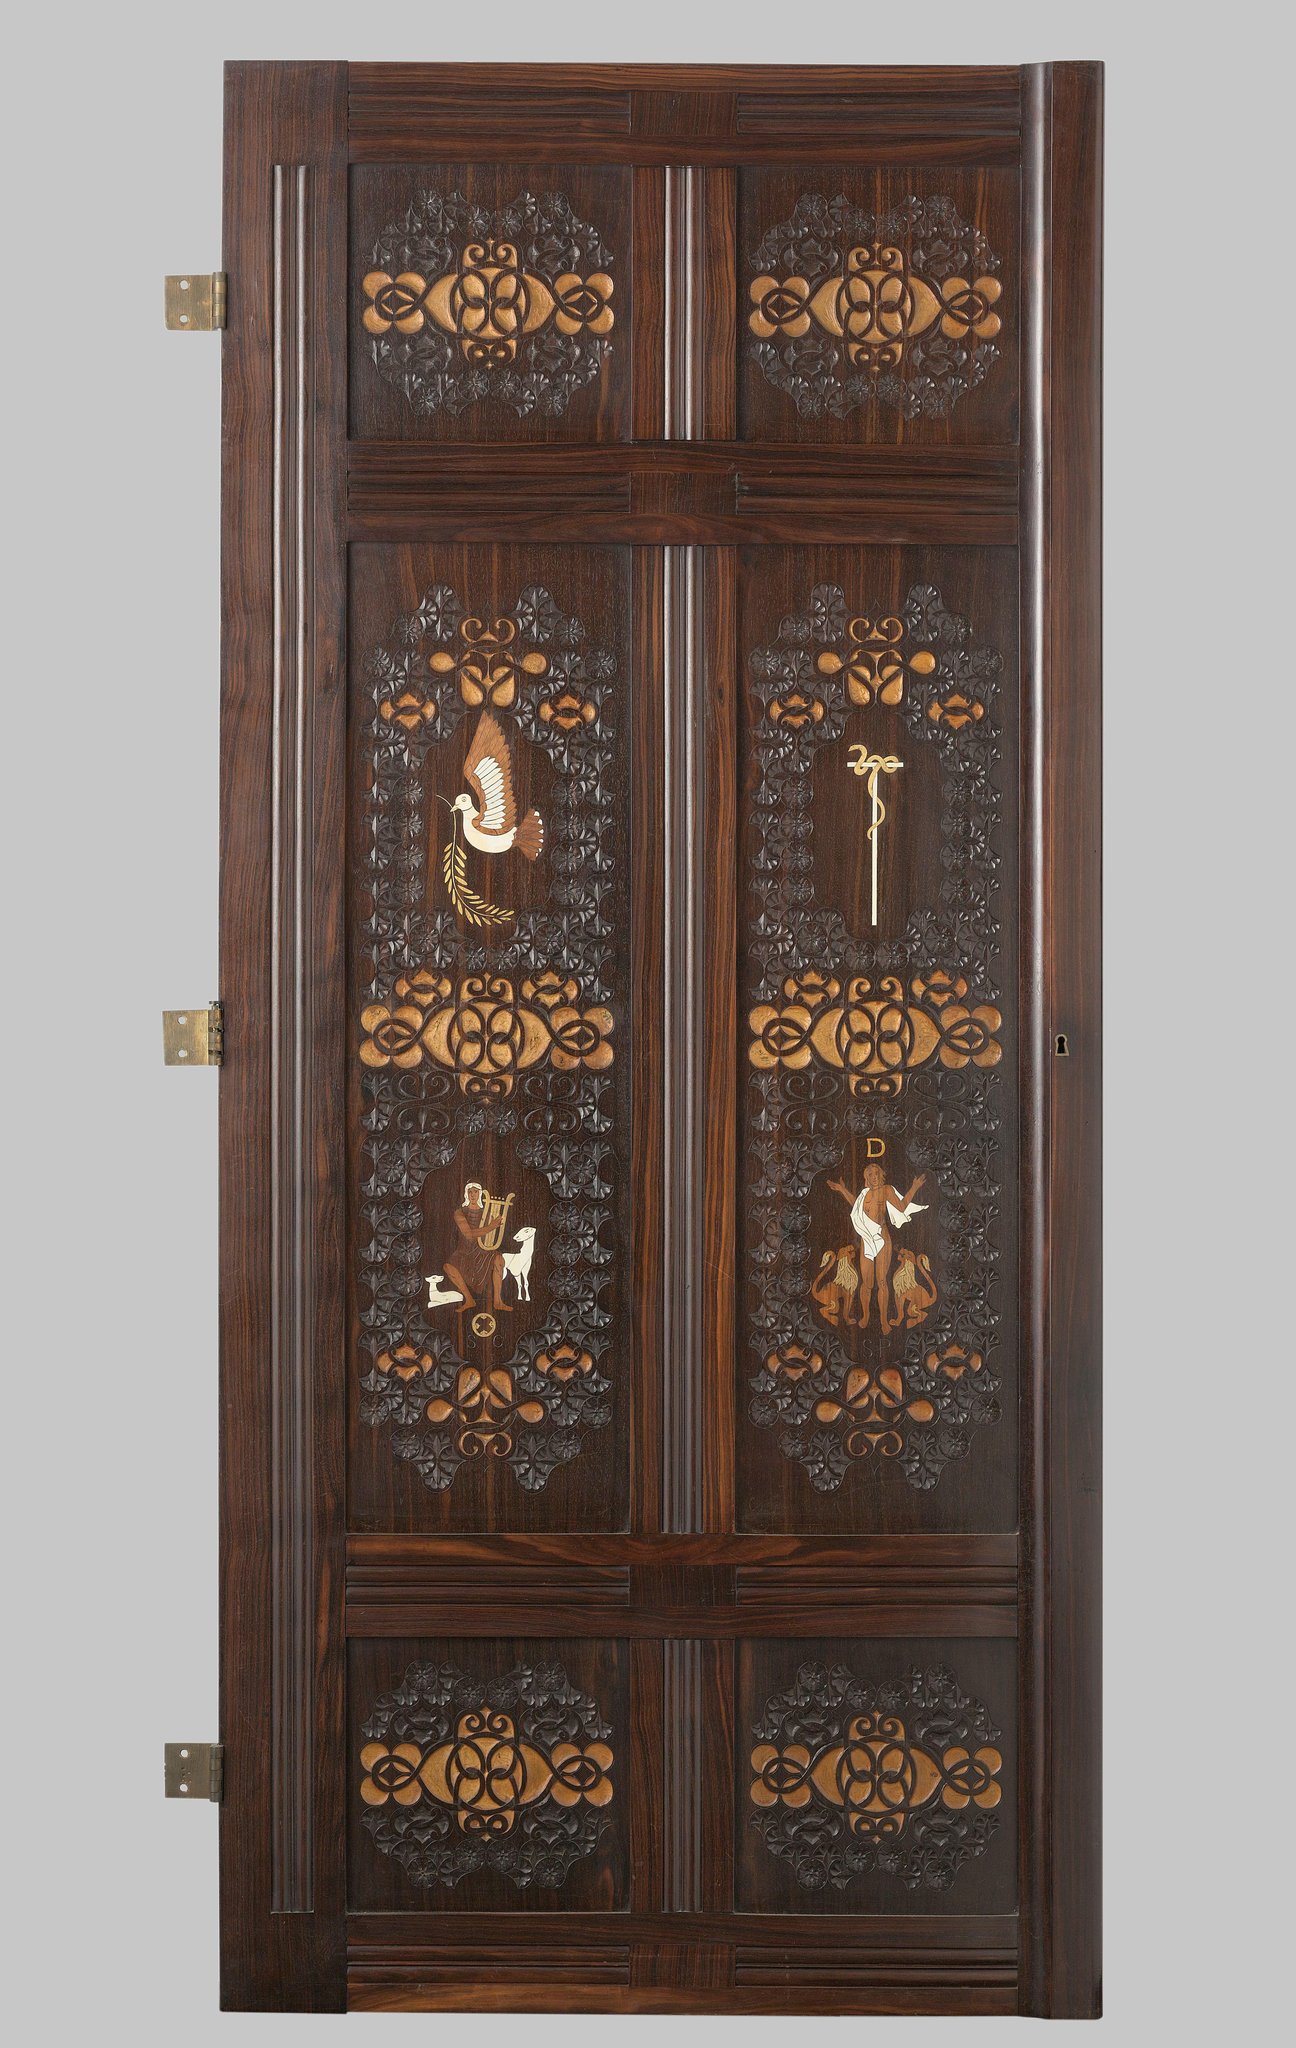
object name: door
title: Kastdeur van coromandelhout met duif, Orpheus, staf en Daniël in de leeuwenkuil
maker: carel adolph lion cachet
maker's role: draughtsman, print maker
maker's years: 1864-1945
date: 1900-1905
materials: brass, copper, wood, ivory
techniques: gilding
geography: amsterdam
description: Two cupboard doors, Macassar ebony, partly gilt and inlaid with walnut, ivory and brass Amsterdam, E.J. van Wisselingh and Co, 1902, designed by C.A. Lion Cachet The doors come from the panelling of a room in the house of T.G. Dentz van Schaick, on Frederiksplein 48/50, in Amsterdam.